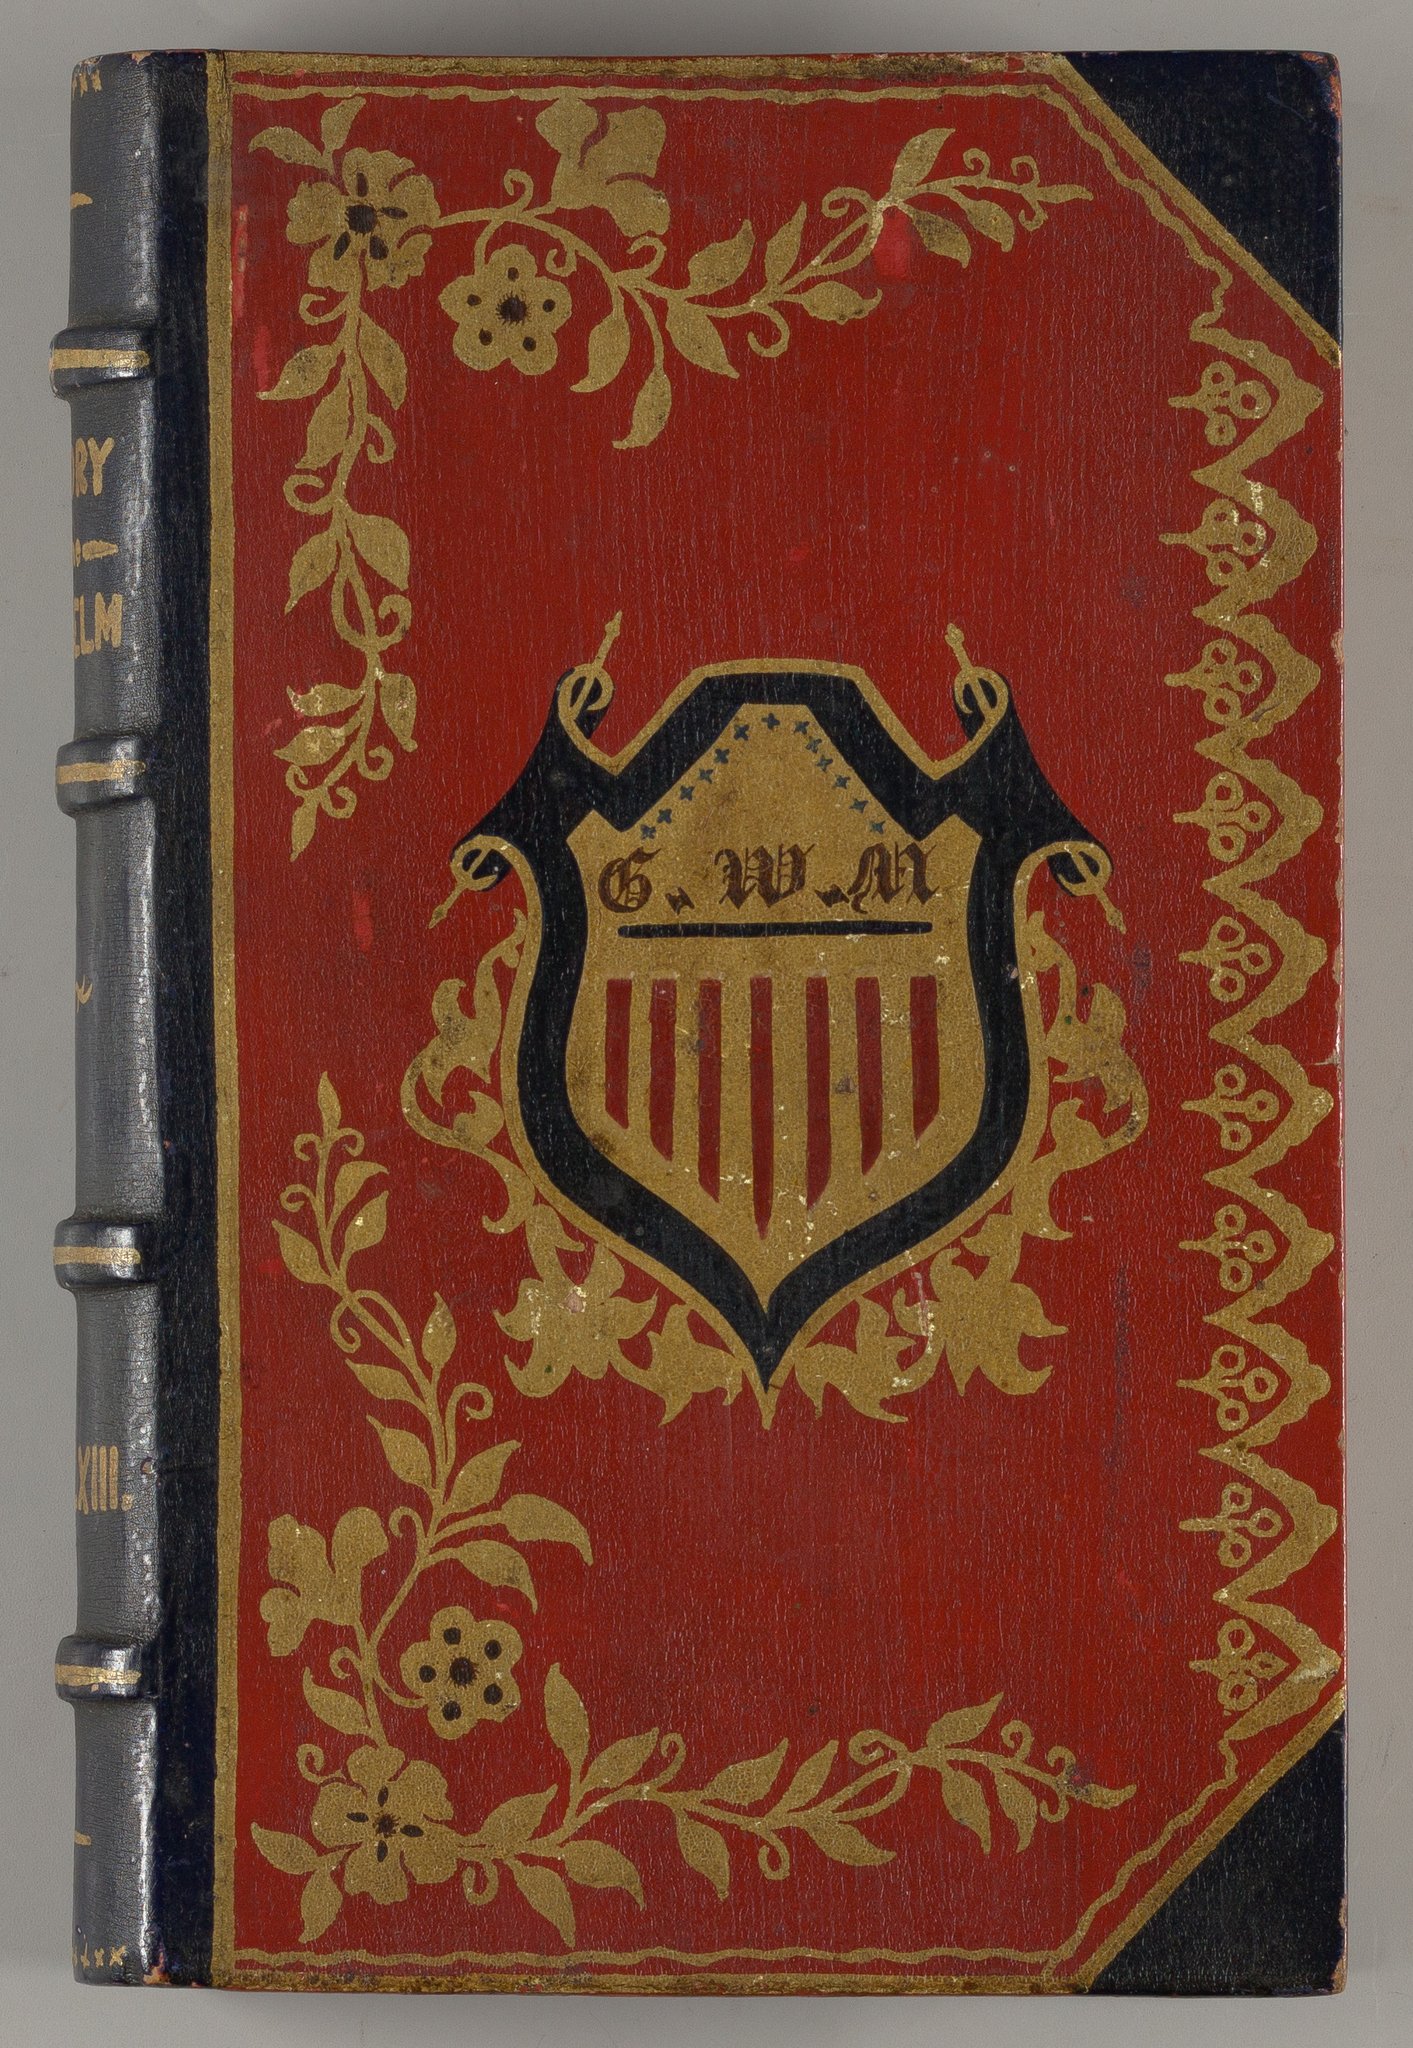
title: History of the Old Elm, Vol. XIII.; G. W. M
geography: cambridge, boston